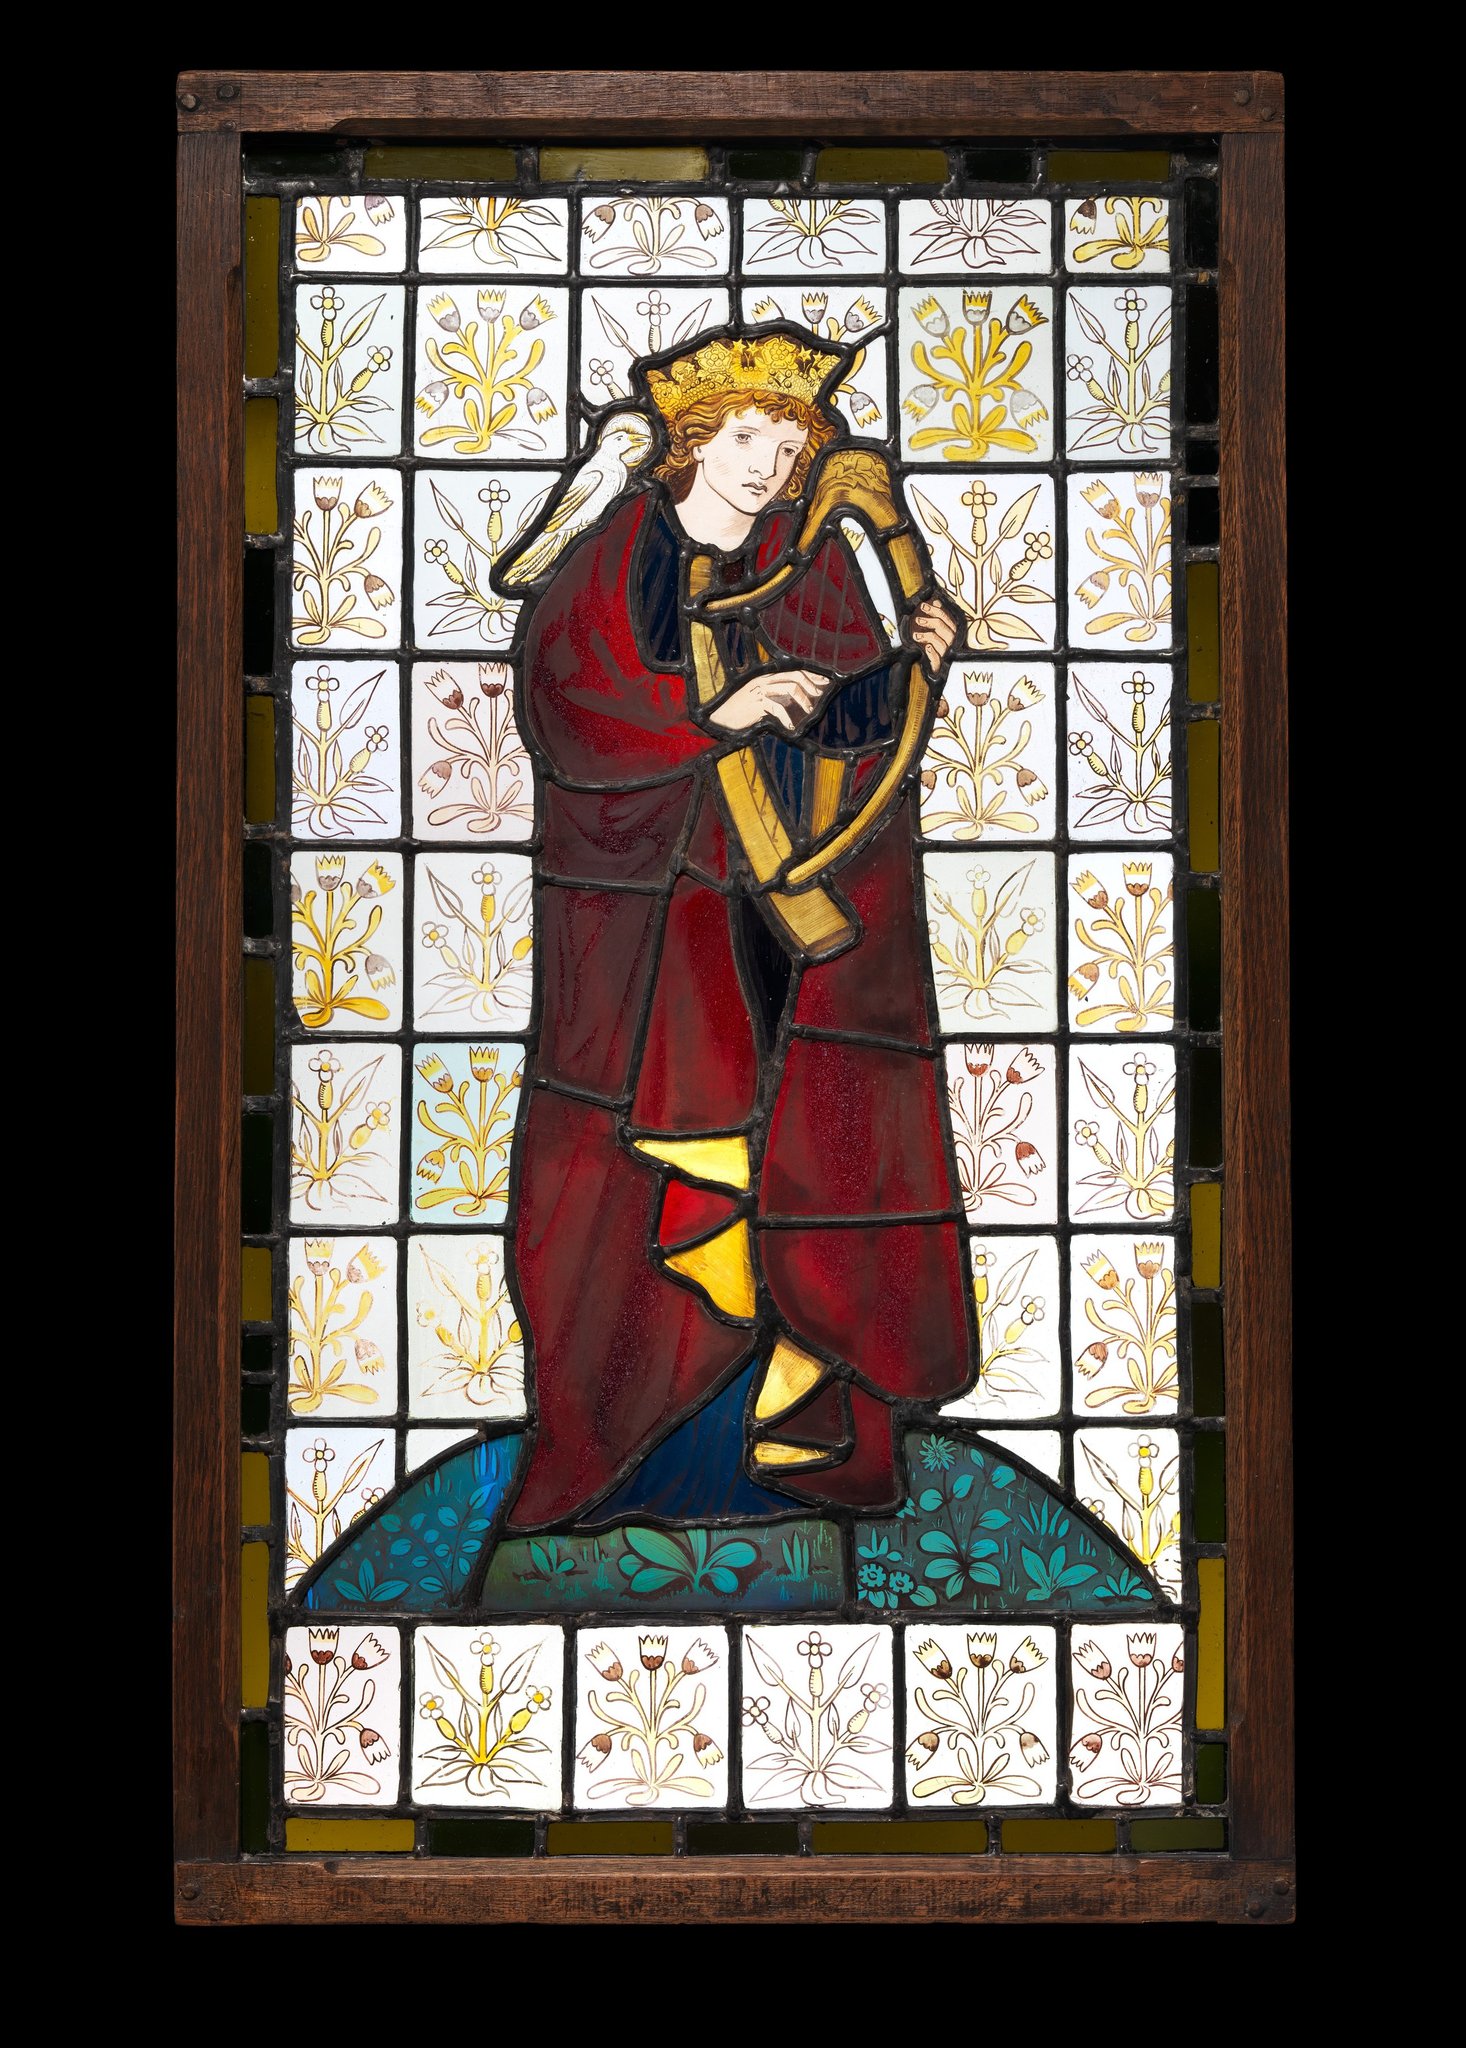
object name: panel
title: King David the Poet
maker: sir edward burne-jones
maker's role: artist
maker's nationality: british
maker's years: 1833-1898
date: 1863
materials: glass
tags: birds,kings,harps,flowers